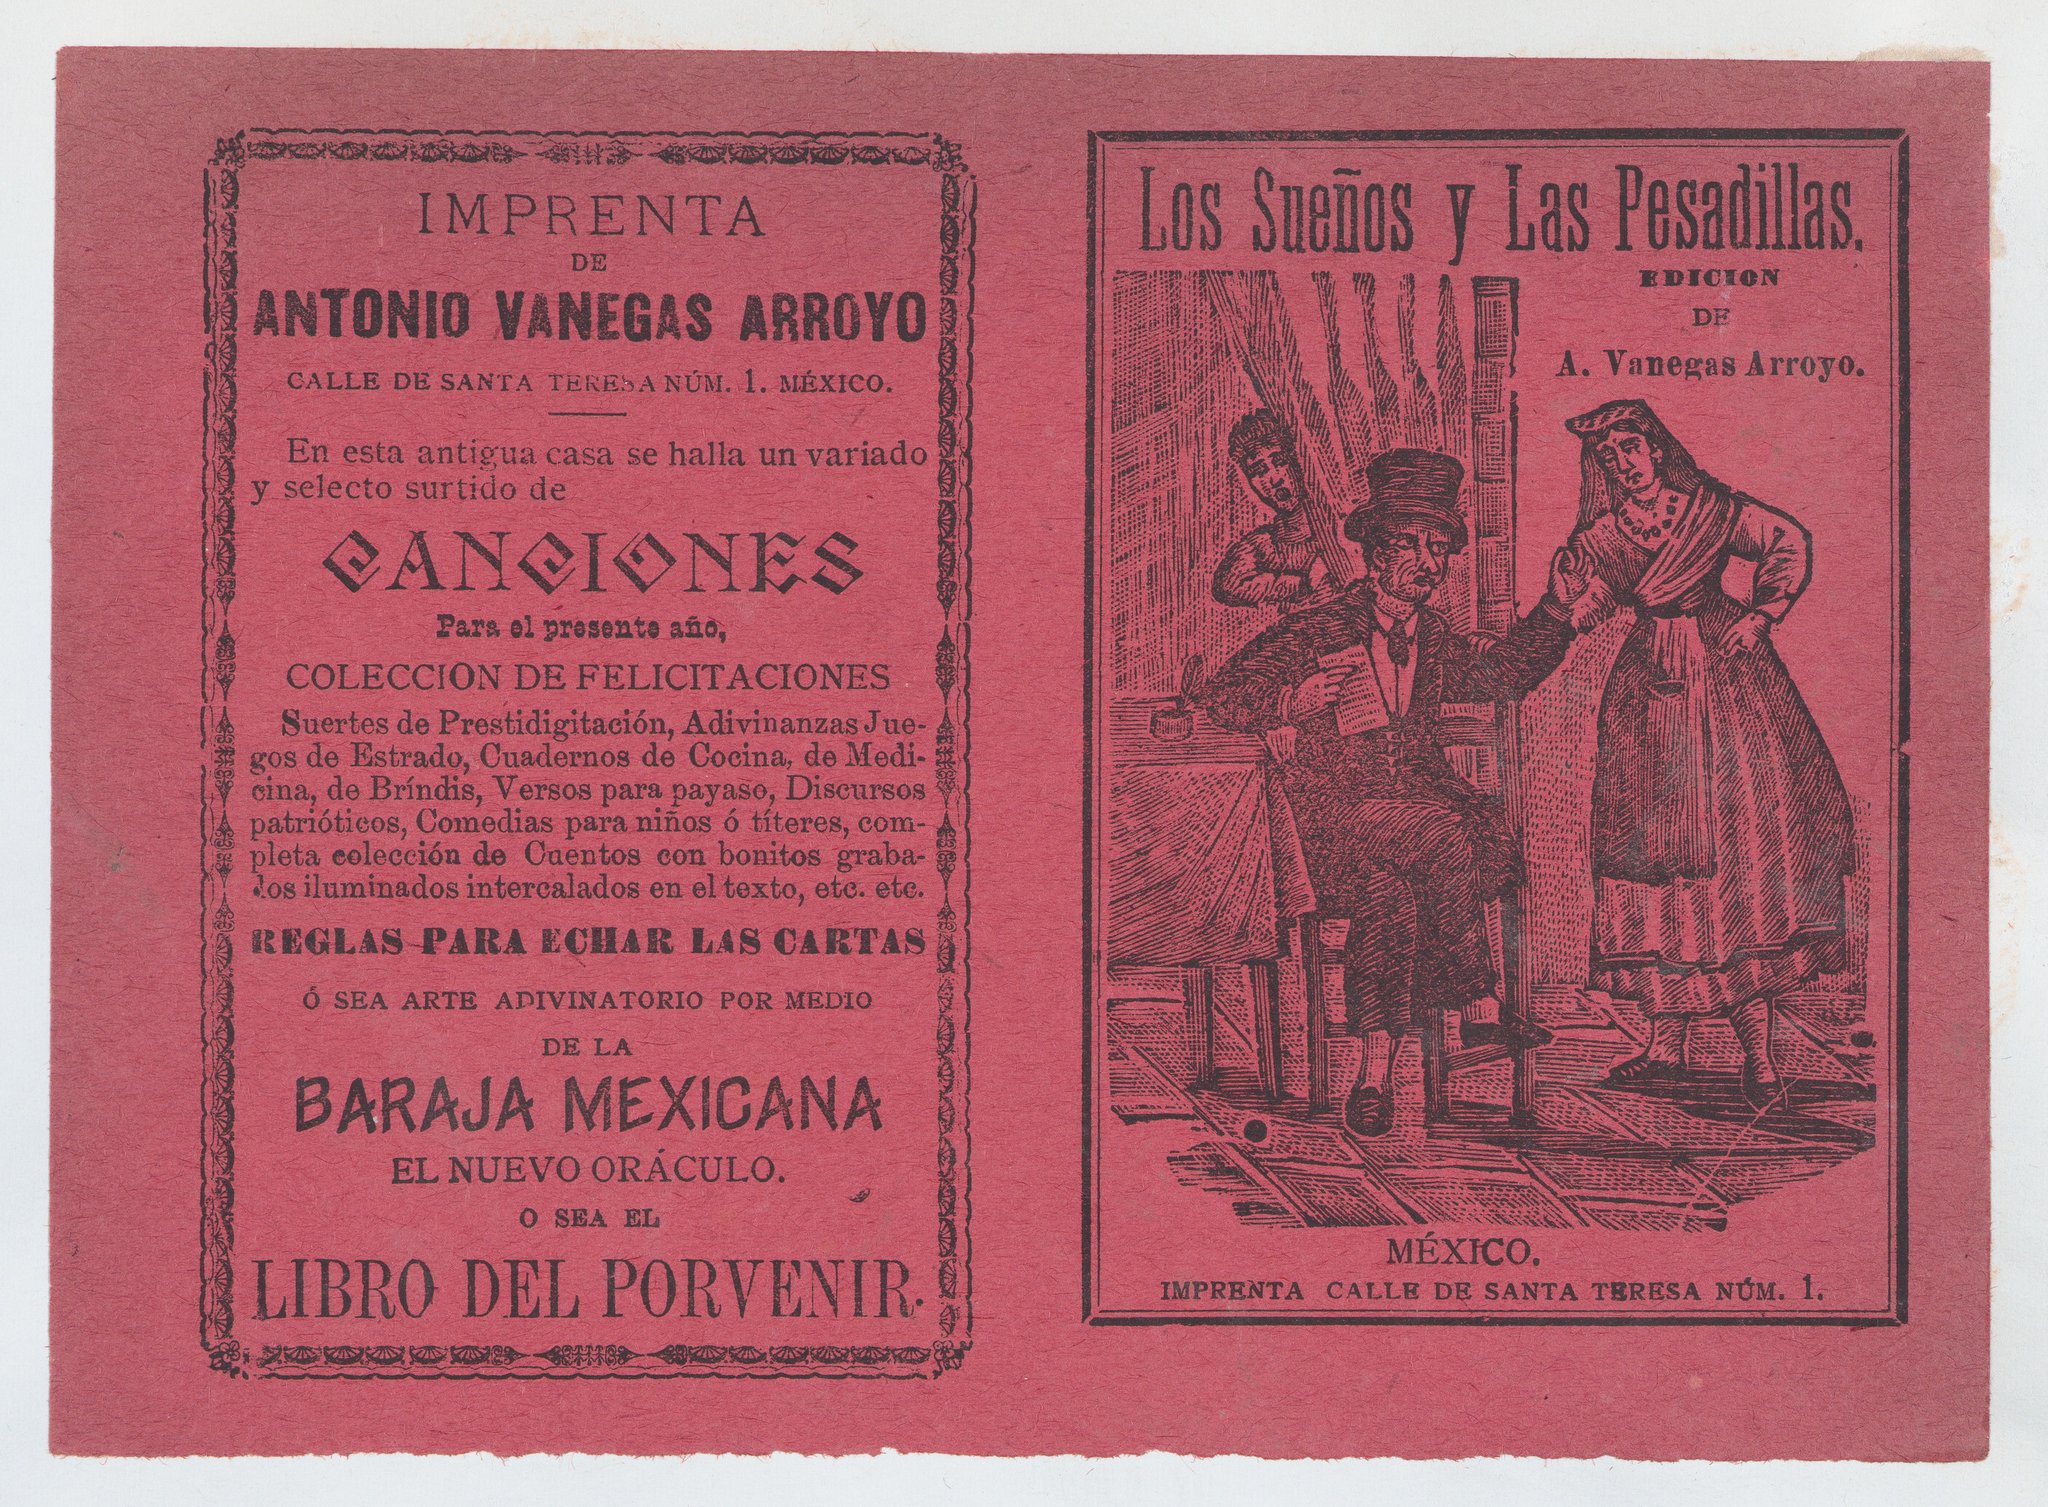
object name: print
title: Cover for 'Los Sueños y Las Pesadillas', a man and woman arguing while another figure peers out from behind a curtain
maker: josé guadalupe posada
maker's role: artist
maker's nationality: mexican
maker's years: 1852-1913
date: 1880-1910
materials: metal, paper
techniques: engraving, letterpress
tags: men,women